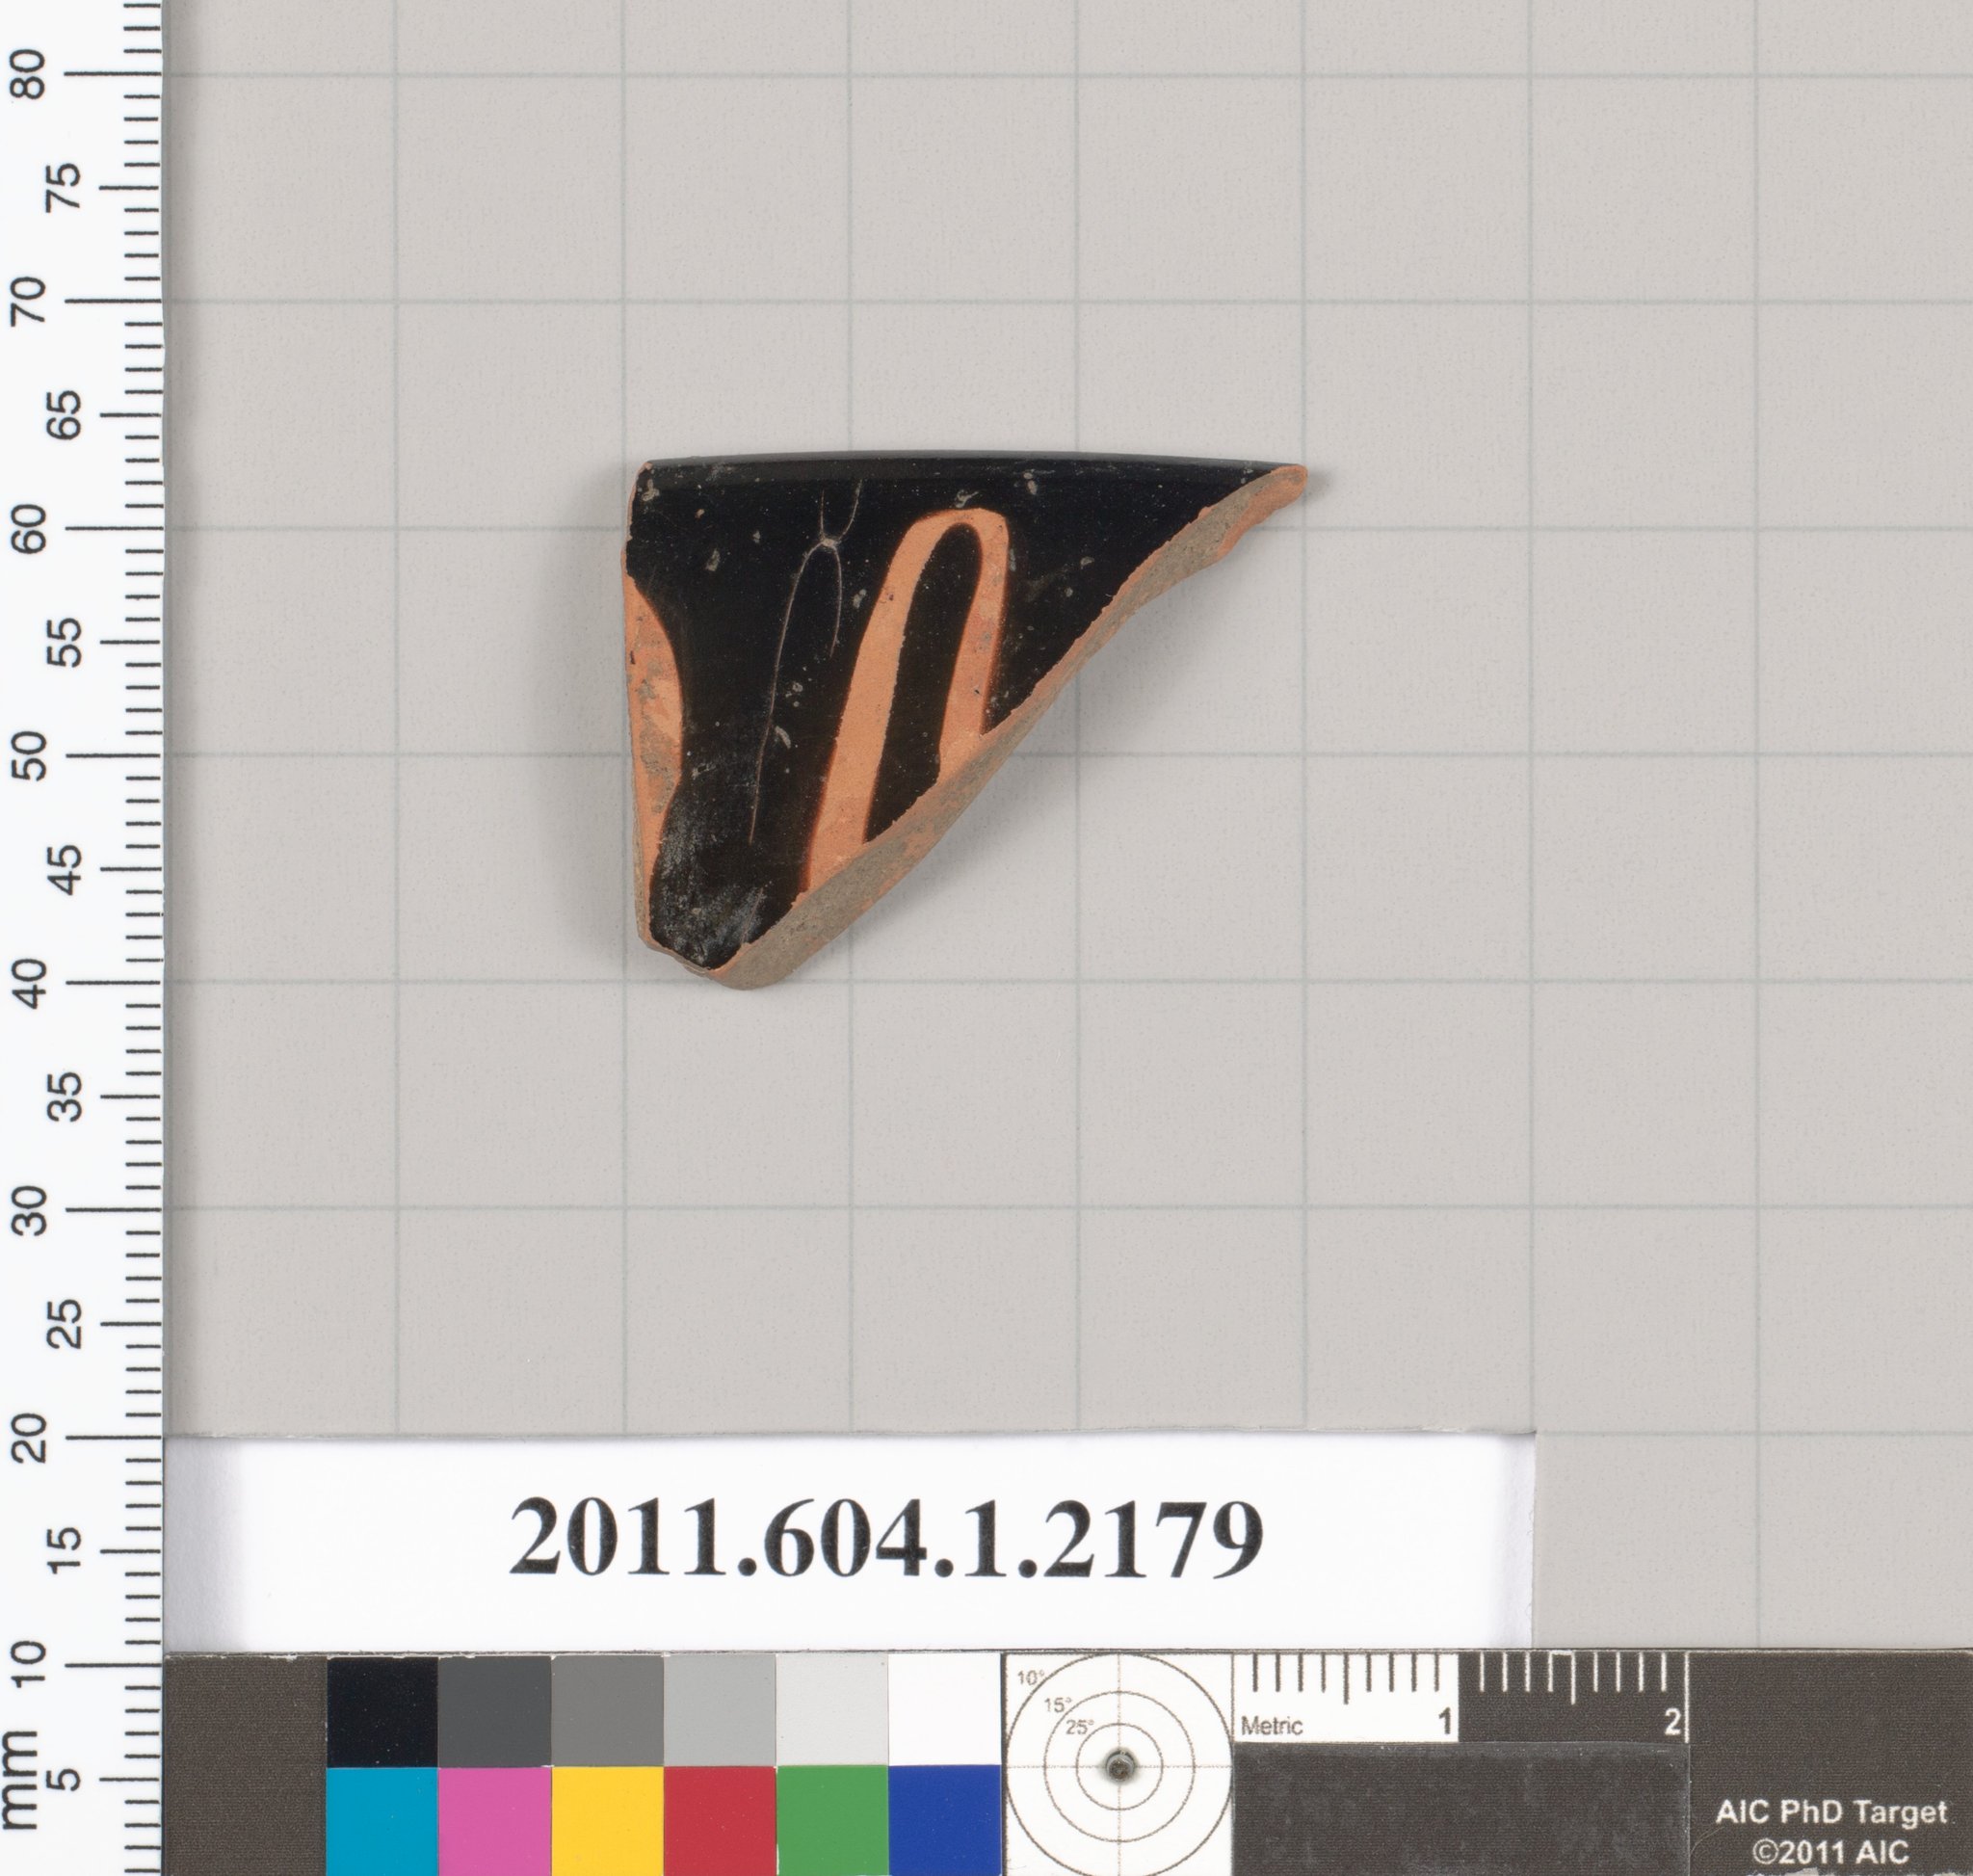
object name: kylix fragment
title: Terracotta rim fragment of a kylix (drinking cup)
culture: greek, attic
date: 467-435 BCE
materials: terracotta